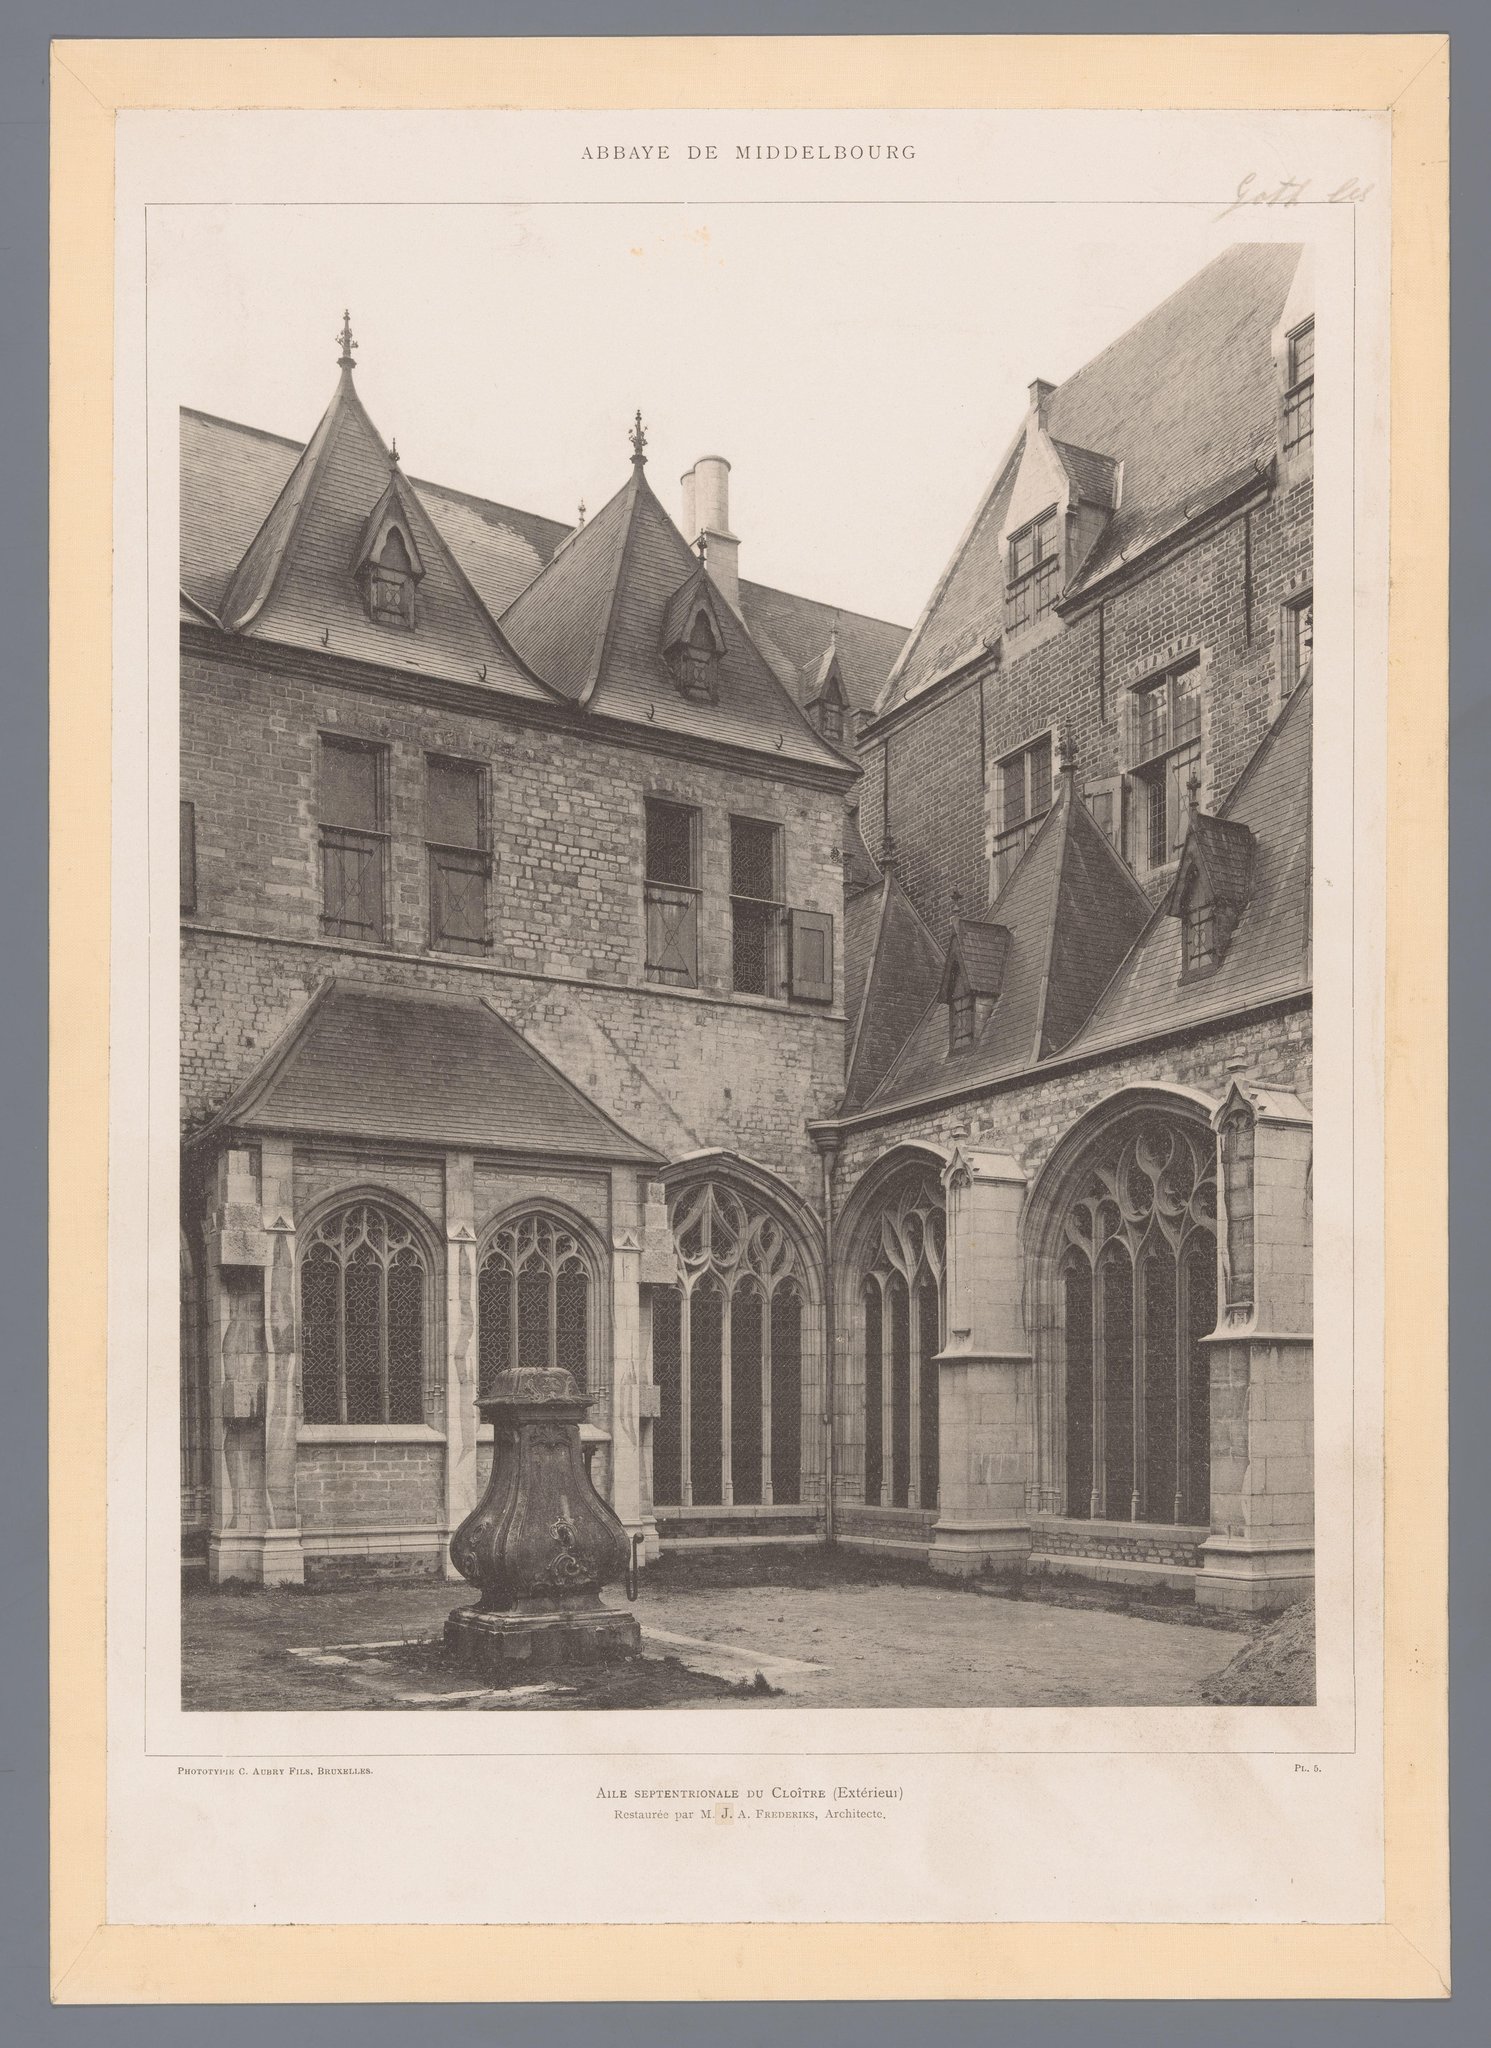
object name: photomechanical print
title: Abbaye de Middelbourg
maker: Anonymous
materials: paper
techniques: photograph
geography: brussels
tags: abbey, monastery, convent ~ roman catholic church, exterior ~ representation of a building